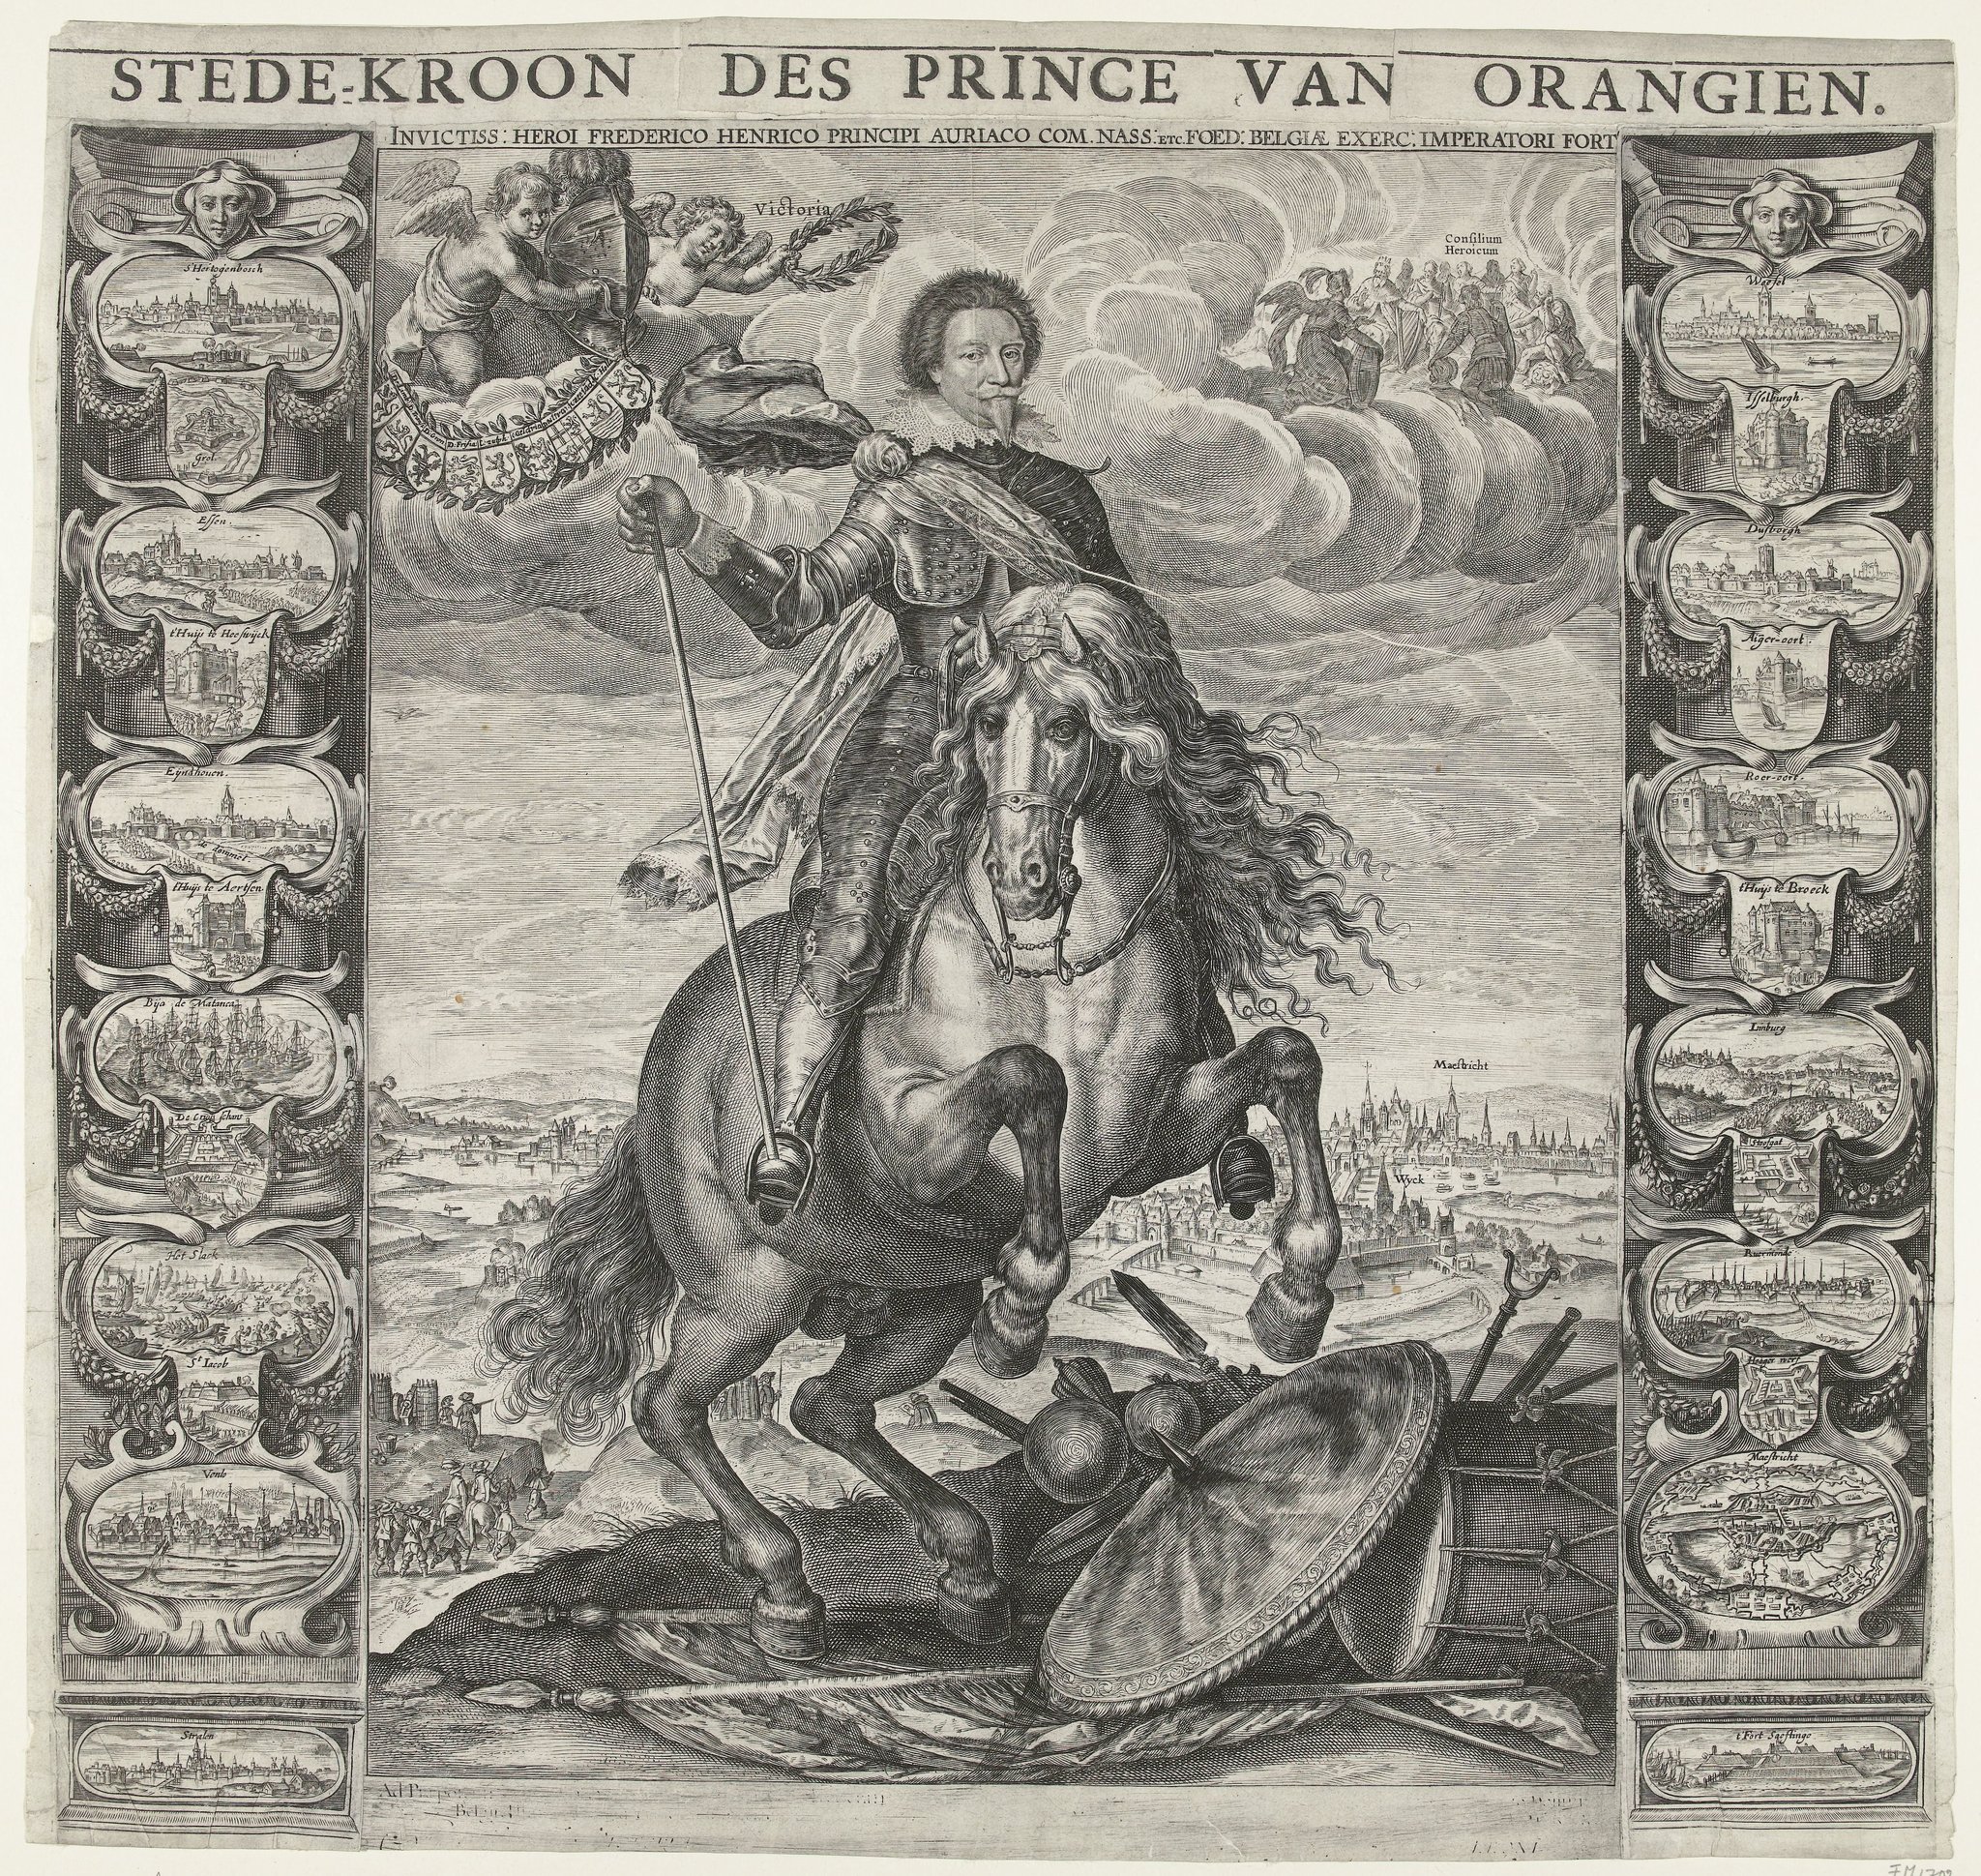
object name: propagandaprent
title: Invictiss: Heroi Frederico Henrico Principi Auriaco Com. Nass. etc. Foed. Belgiae Exerc. Imperatori Fort.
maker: crispijn van de passe (i)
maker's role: draughtsman, print maker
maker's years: 1564-1637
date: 1632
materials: paper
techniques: engraving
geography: northern netherlands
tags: delft, the hague, frederick henry (prince of orange), maastricht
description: Allegorisch ruiterportret van Frederik Hendrik na de verovering van Maastricht, augustus 1632. De stadhouder op een steigerend paard, voor de voeten wapentuig. In de lucht links twee engelen met helm, krans met provinciewapens en lauwerkrans. Rechts het heldenberaad. Op de achtergrond de stad Maastricht. In de marge zijn nog sporen van de weggepolijste inscriptie. Bovenaan een strook papier geplakt met de titel. Aan weerszijden geplakt twee smalle stroken met door de stadhouder veroverde steden en forten. Bij de prent behoort een tekstblad met verzen.